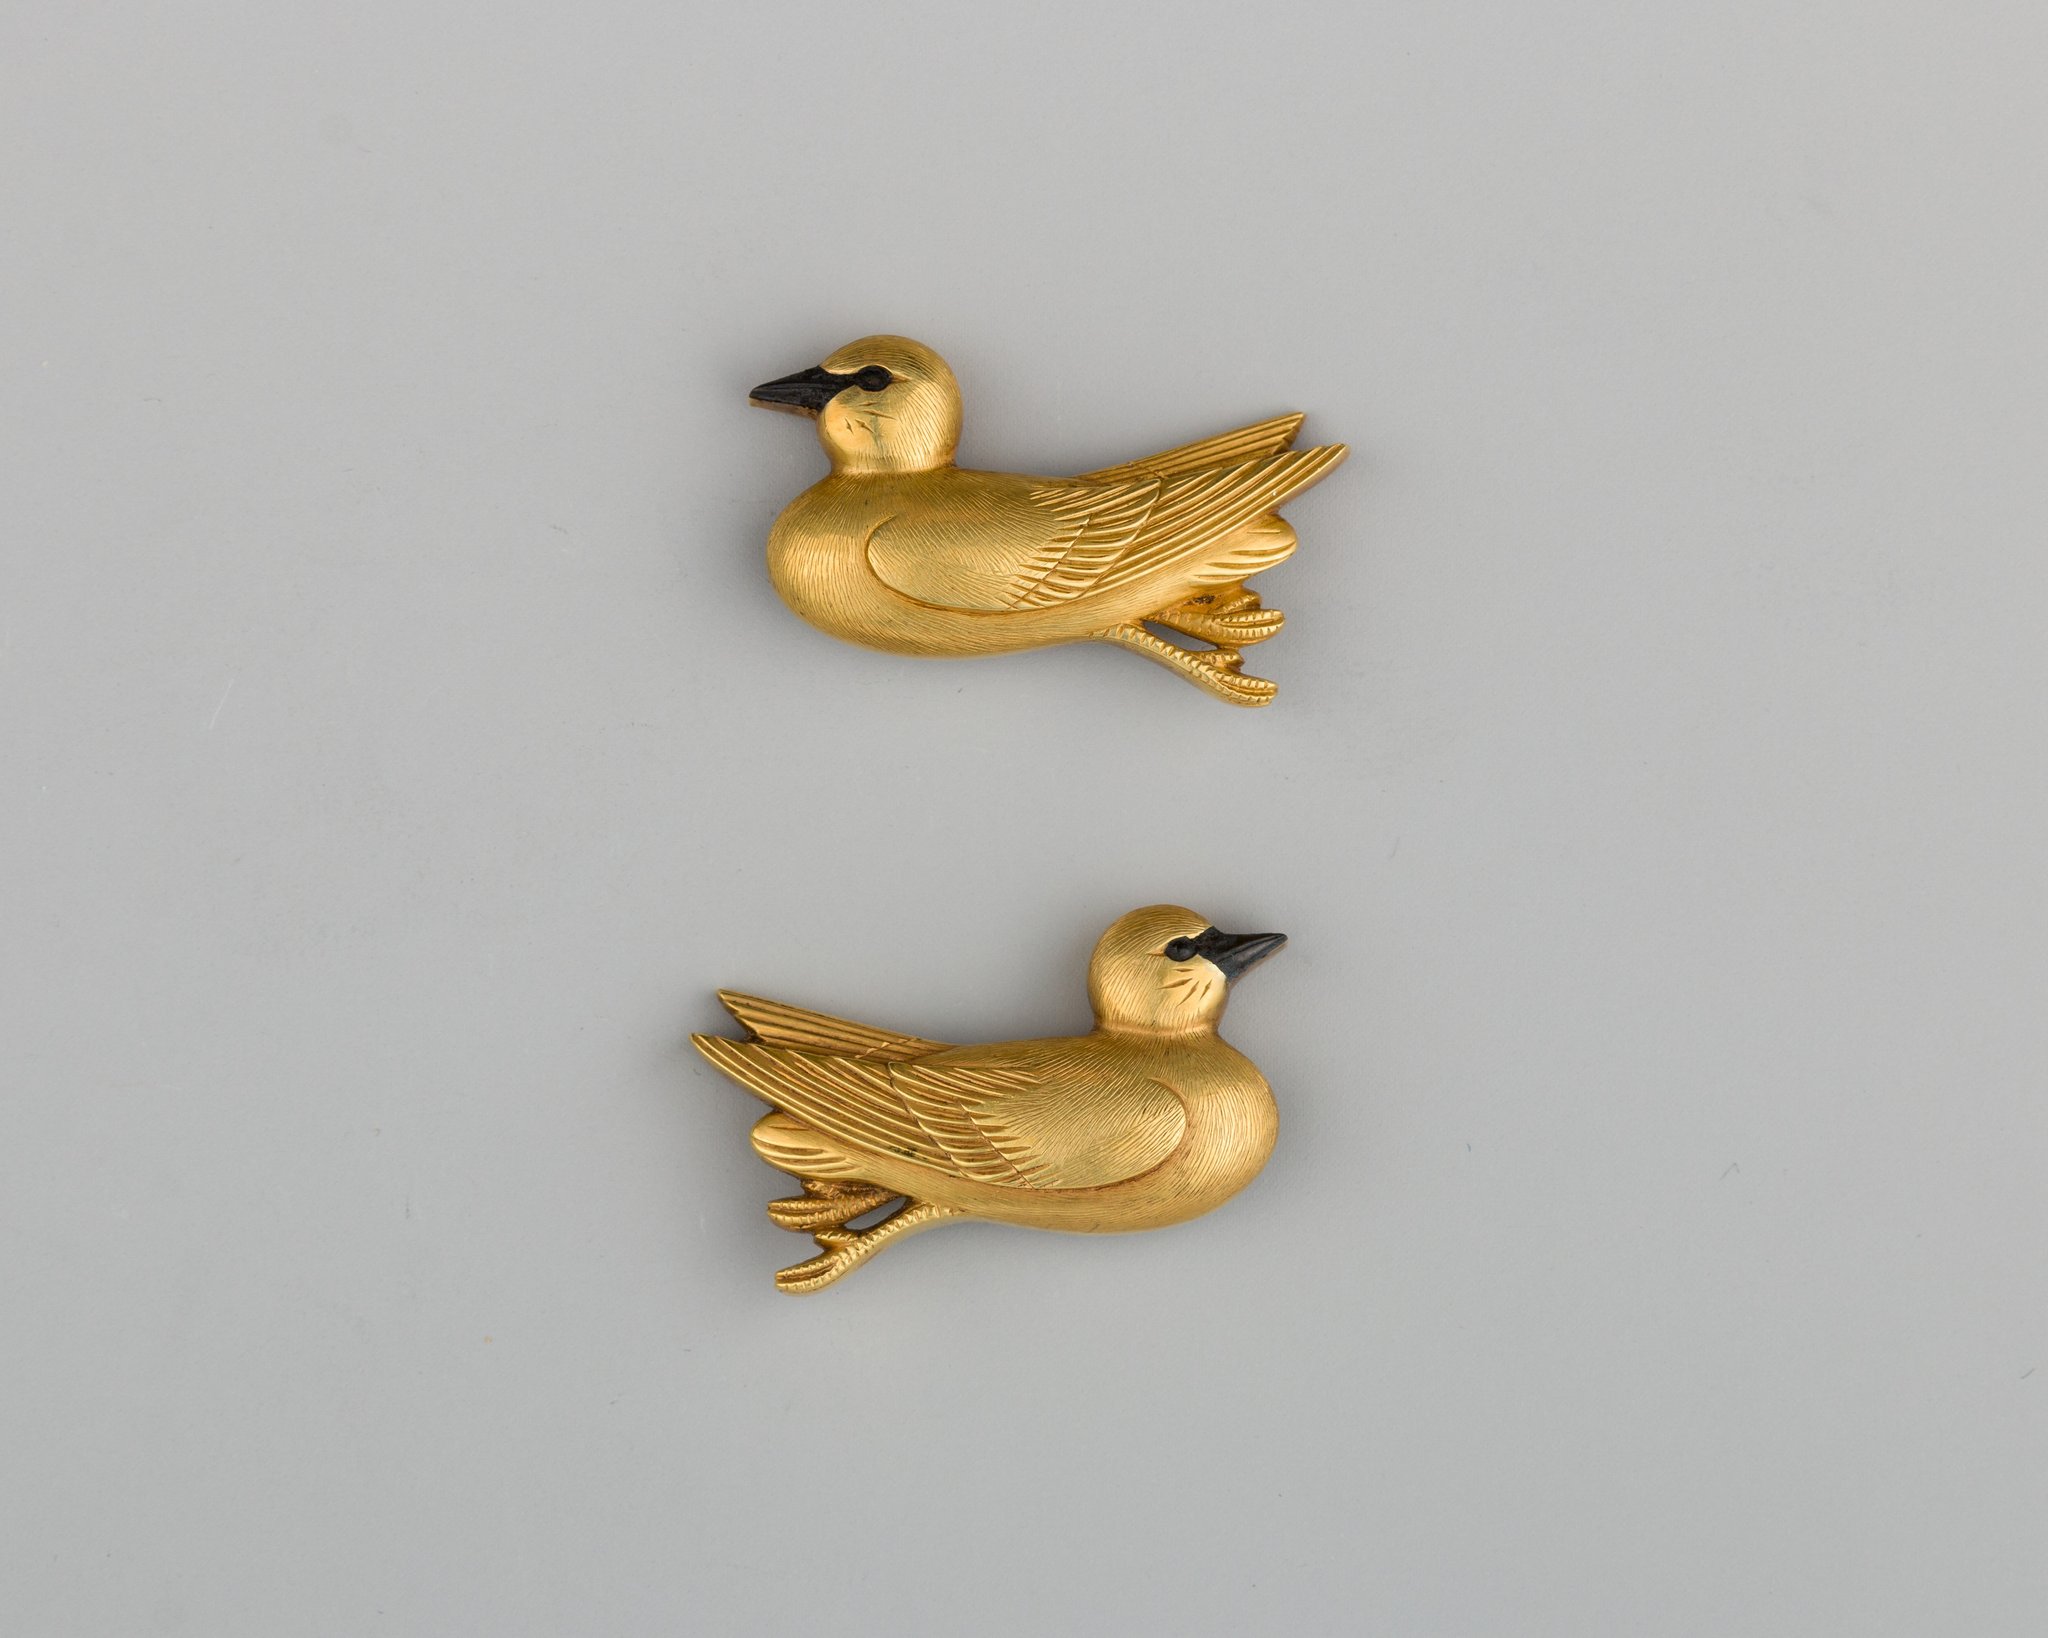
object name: pair of sword grip ornament menuki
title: Pair of Sword-Grip Ornaments (Menuki)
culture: japanese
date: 1701-1800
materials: gold alloy, gold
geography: japan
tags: birds